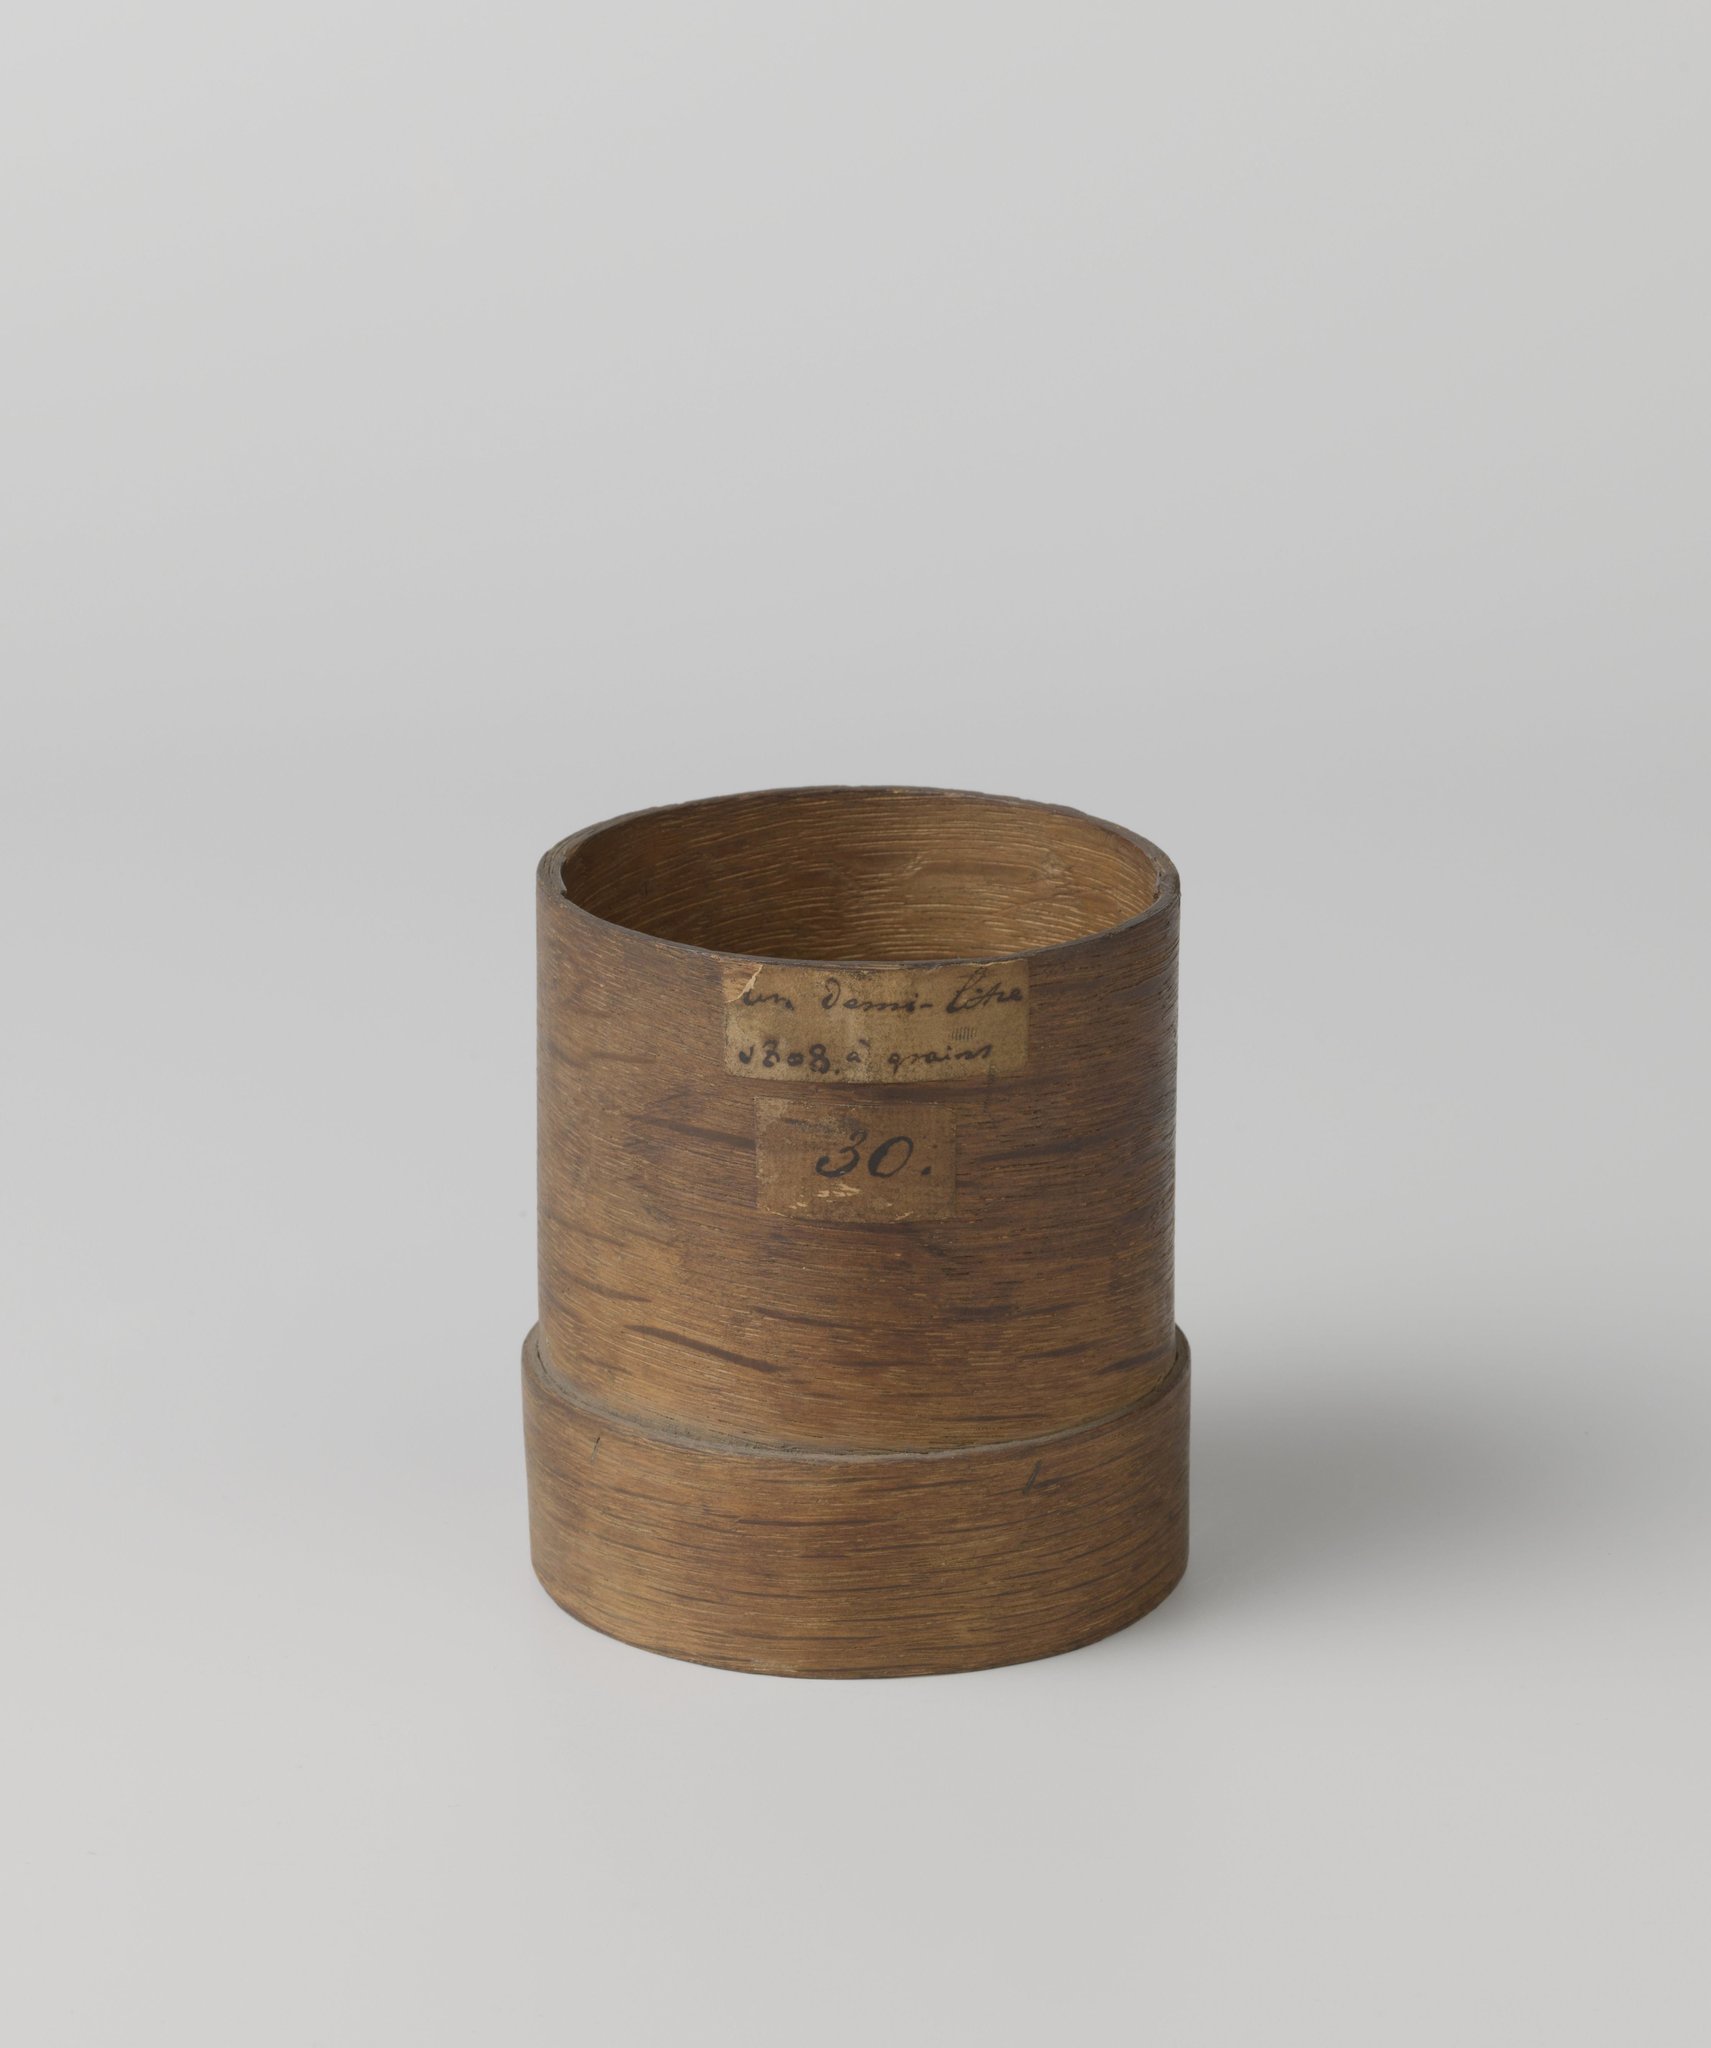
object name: inhoudsmaat droge waren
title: Inhoudsmaat van 1/2 liter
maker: Anonymous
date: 1825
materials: wood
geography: netherlands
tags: netherlands